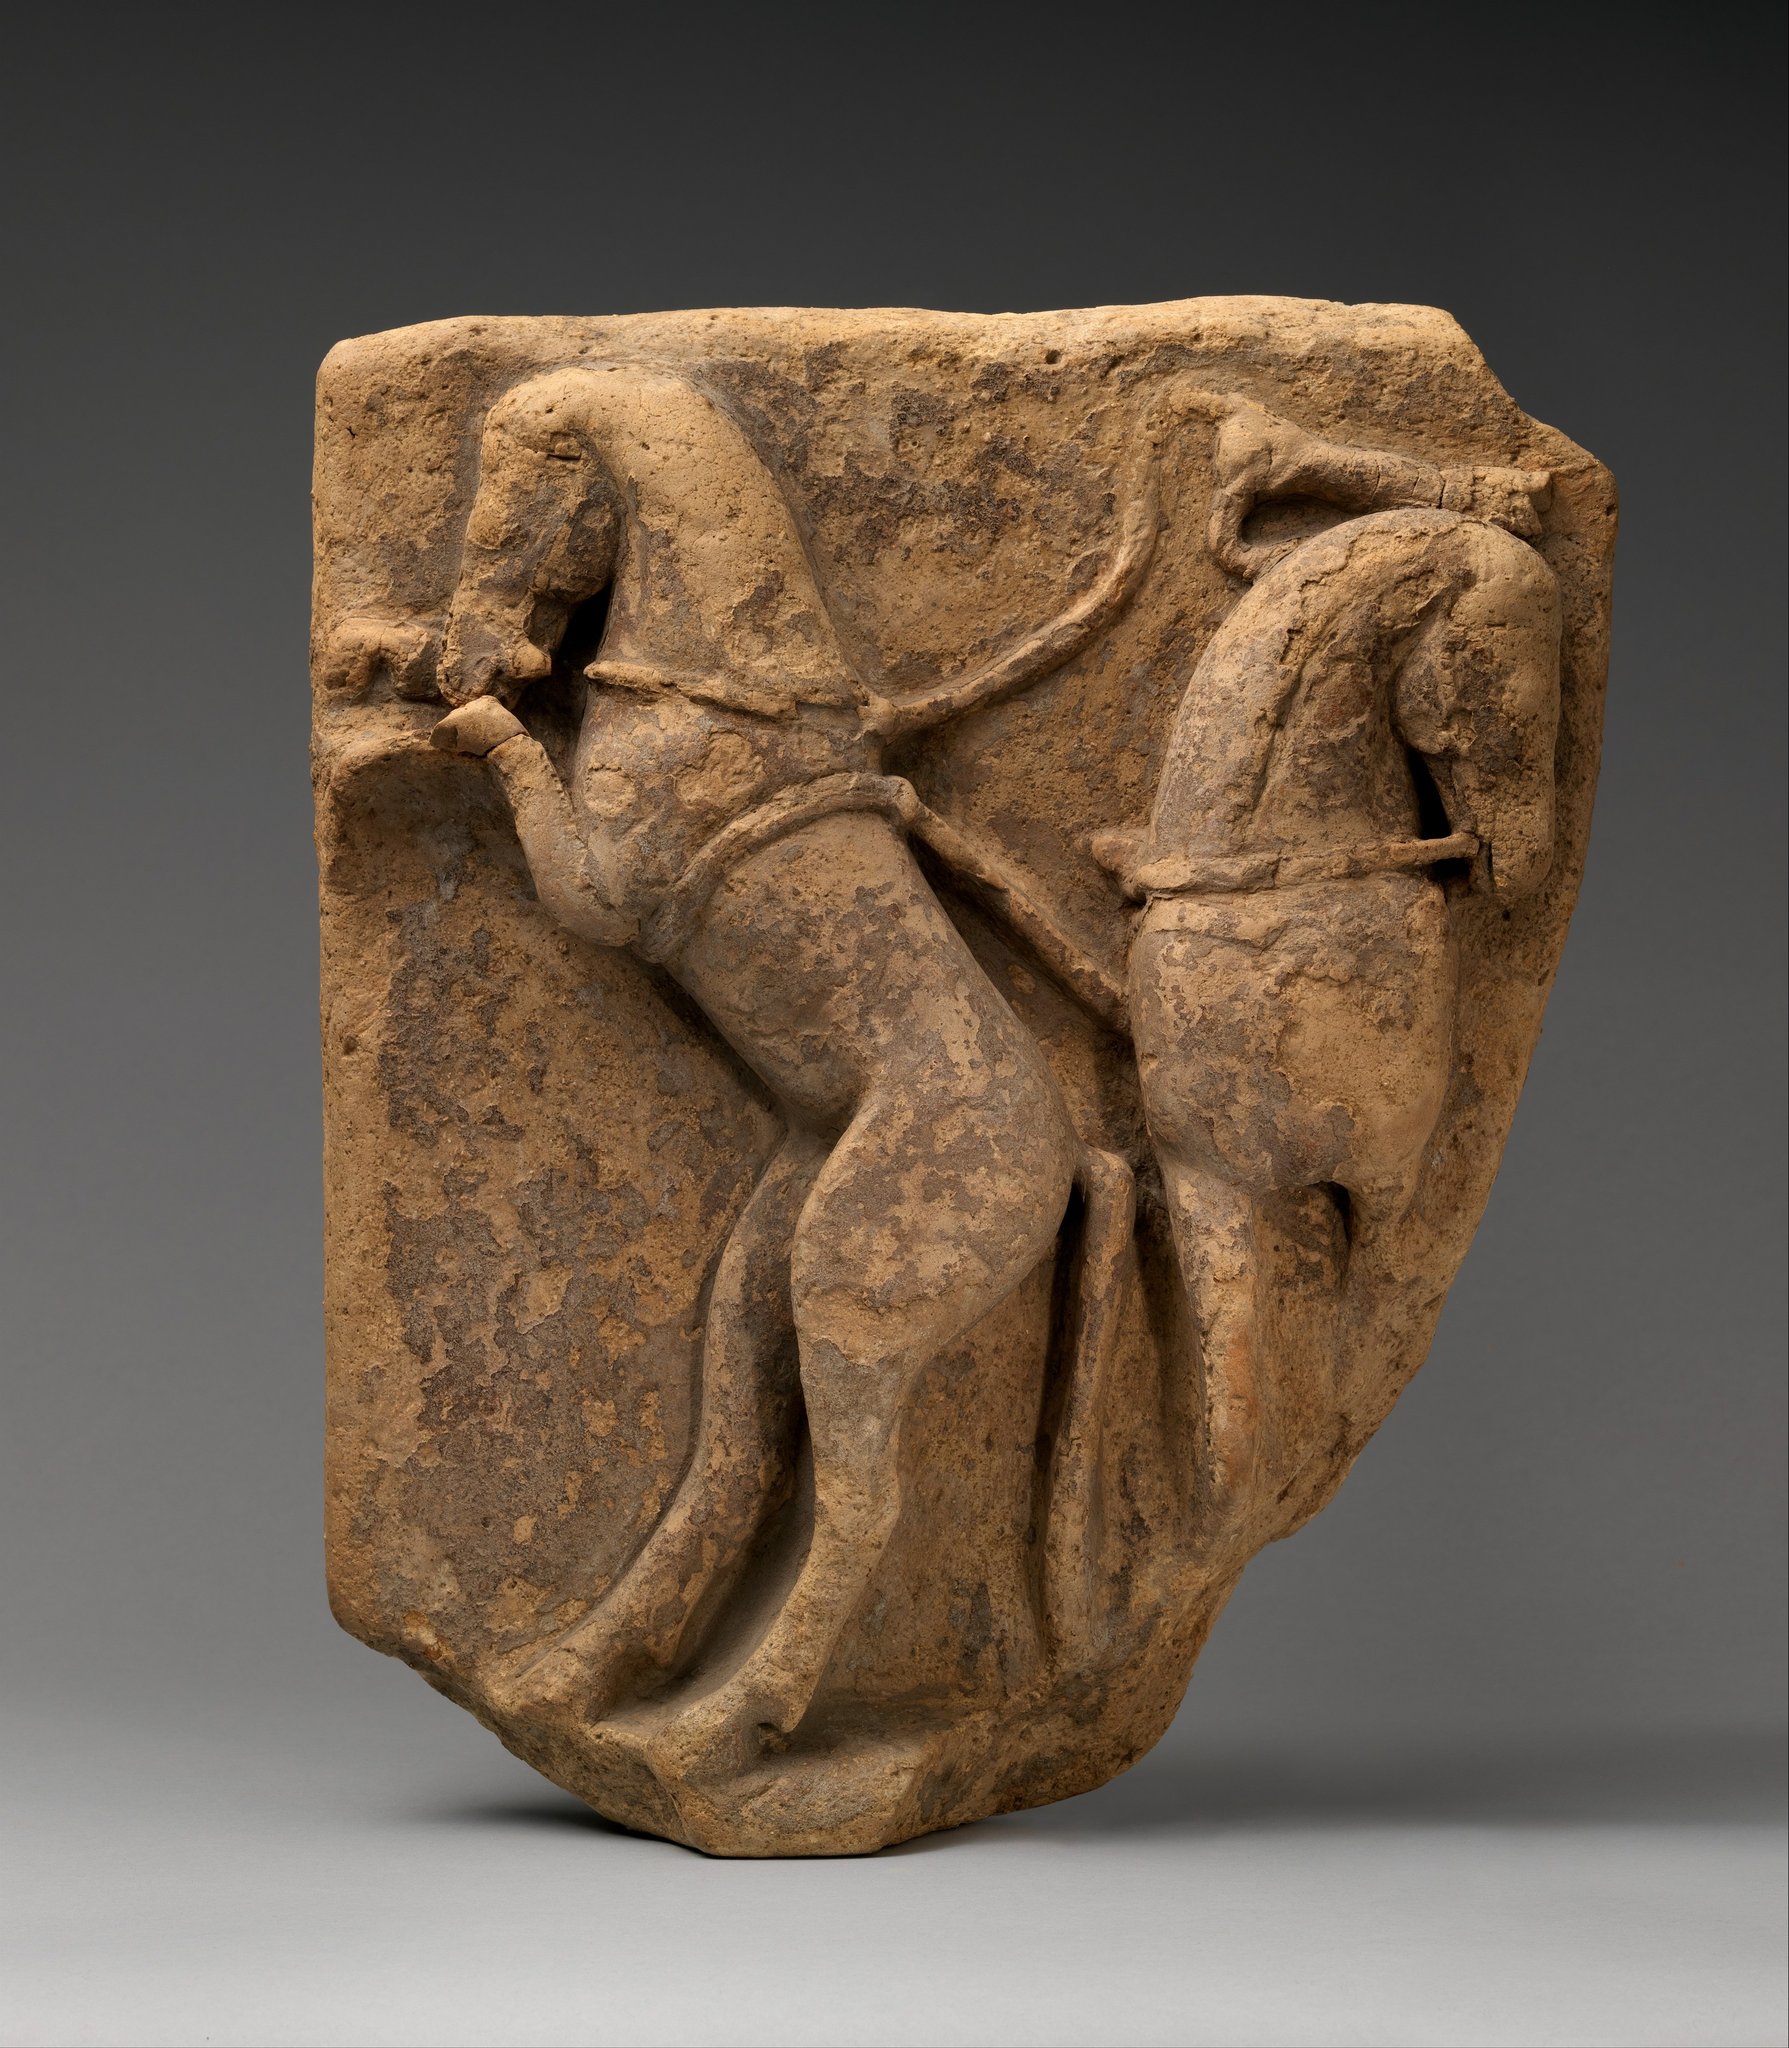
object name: relief of two horse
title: Fragment of a terracotta relief with two horses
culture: greek or south italian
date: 600-501 BCE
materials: terracotta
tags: horses